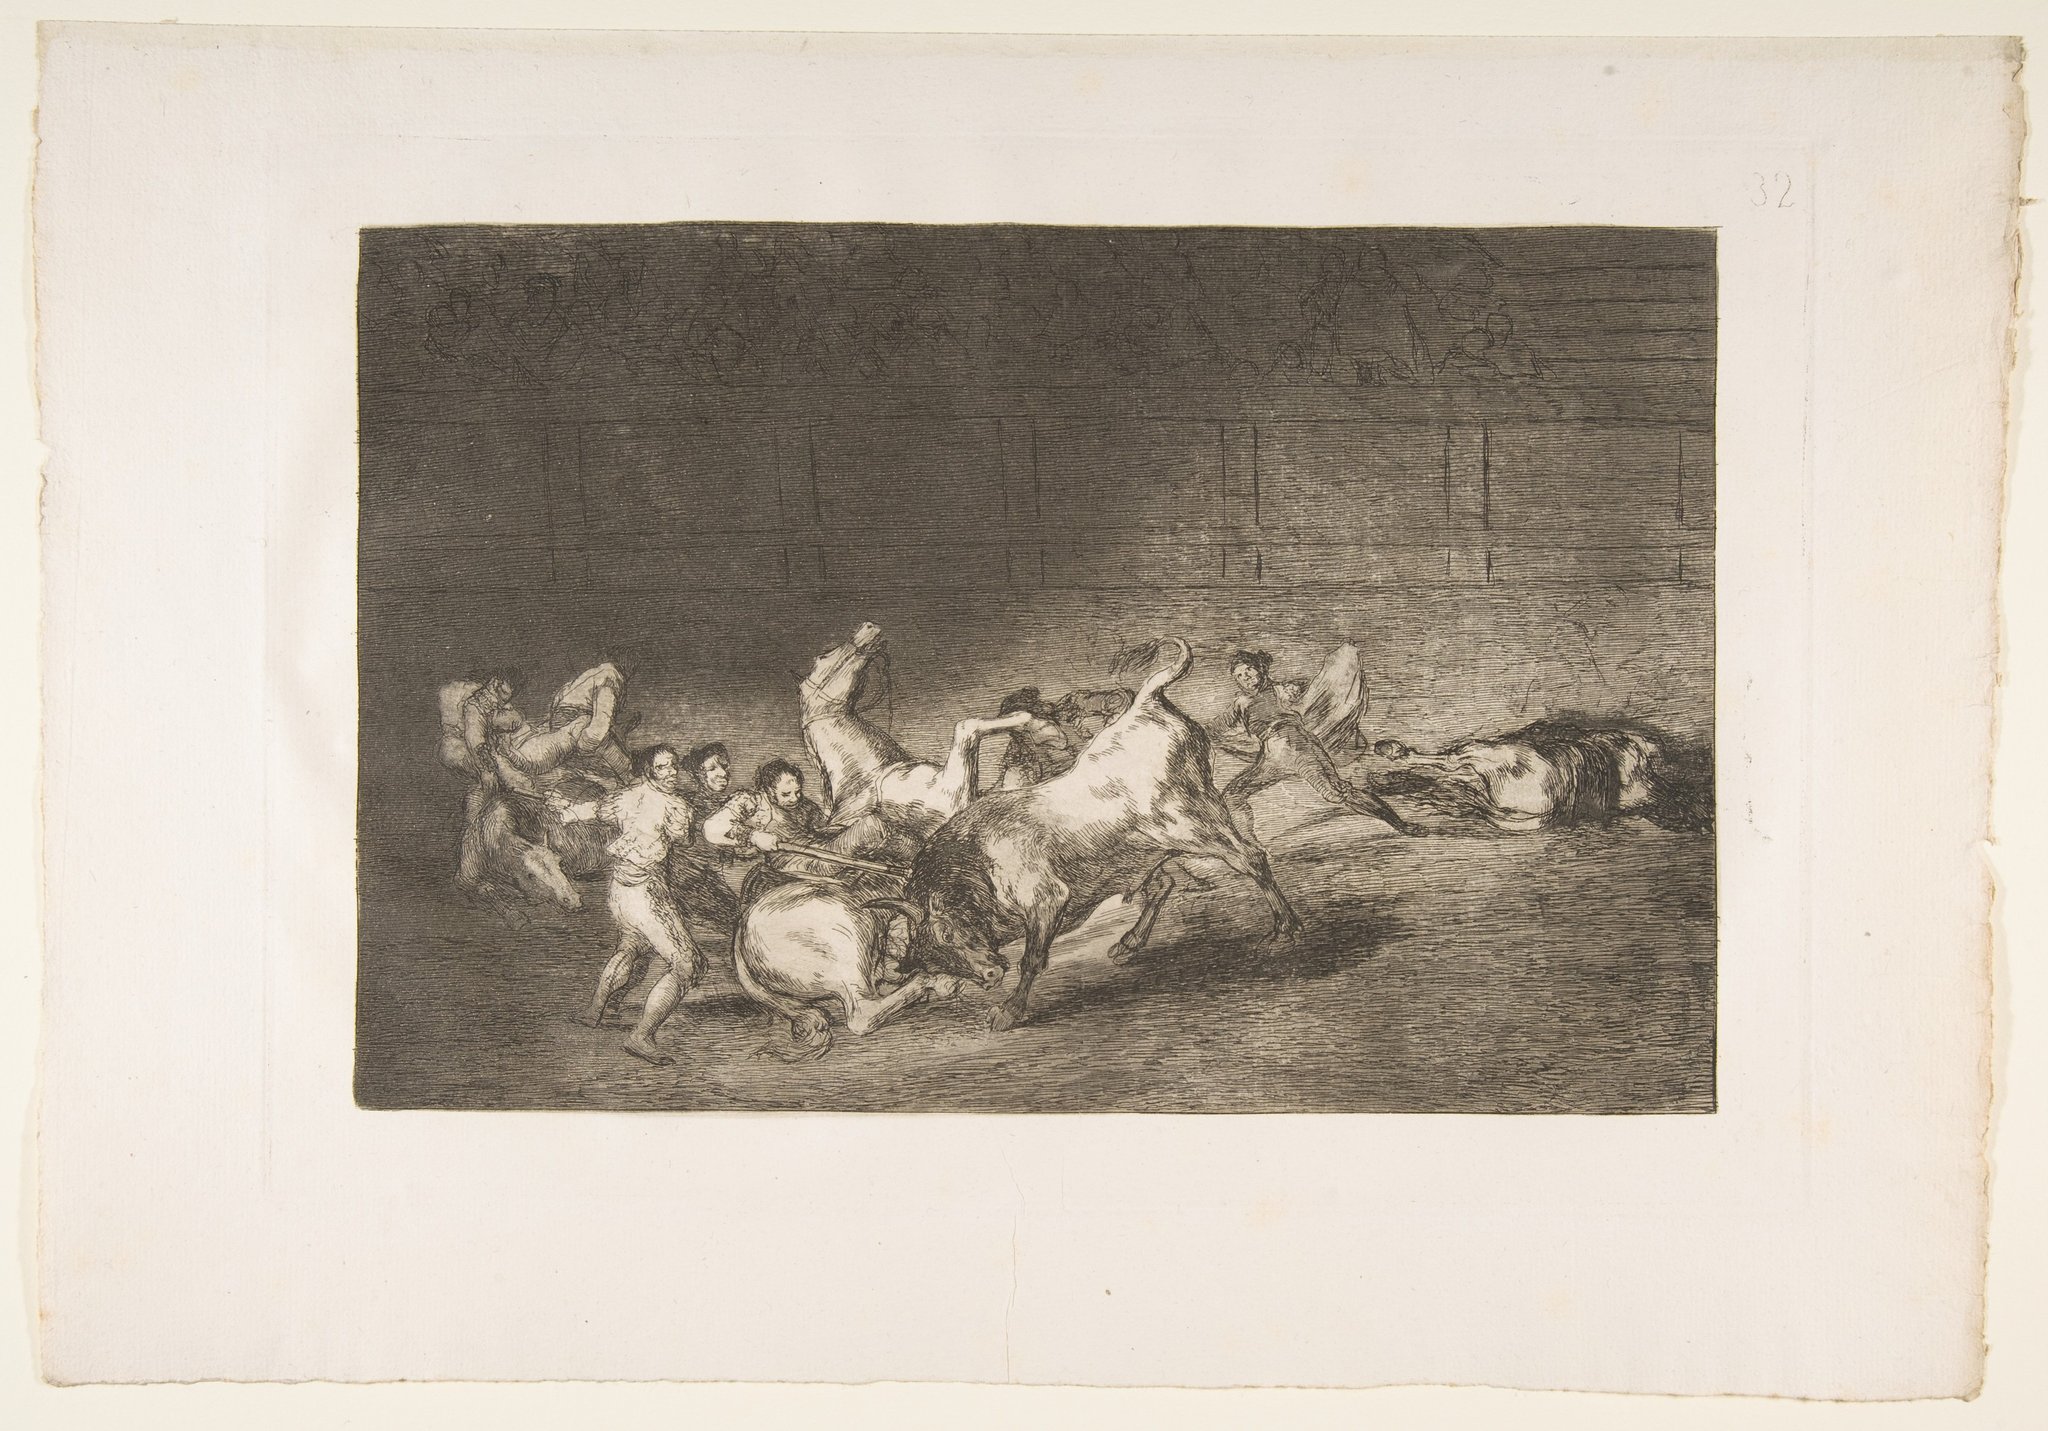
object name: print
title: Plate 32 from "La Tauromaquia": Two teams of picadors thrown one after the other by a single bull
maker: goya (francisco de goya y lucientes)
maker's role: artist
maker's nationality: spanish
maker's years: 1746-1828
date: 1816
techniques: aquatint, engraving, burnishing, drypoint, etching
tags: men,bulls,horses